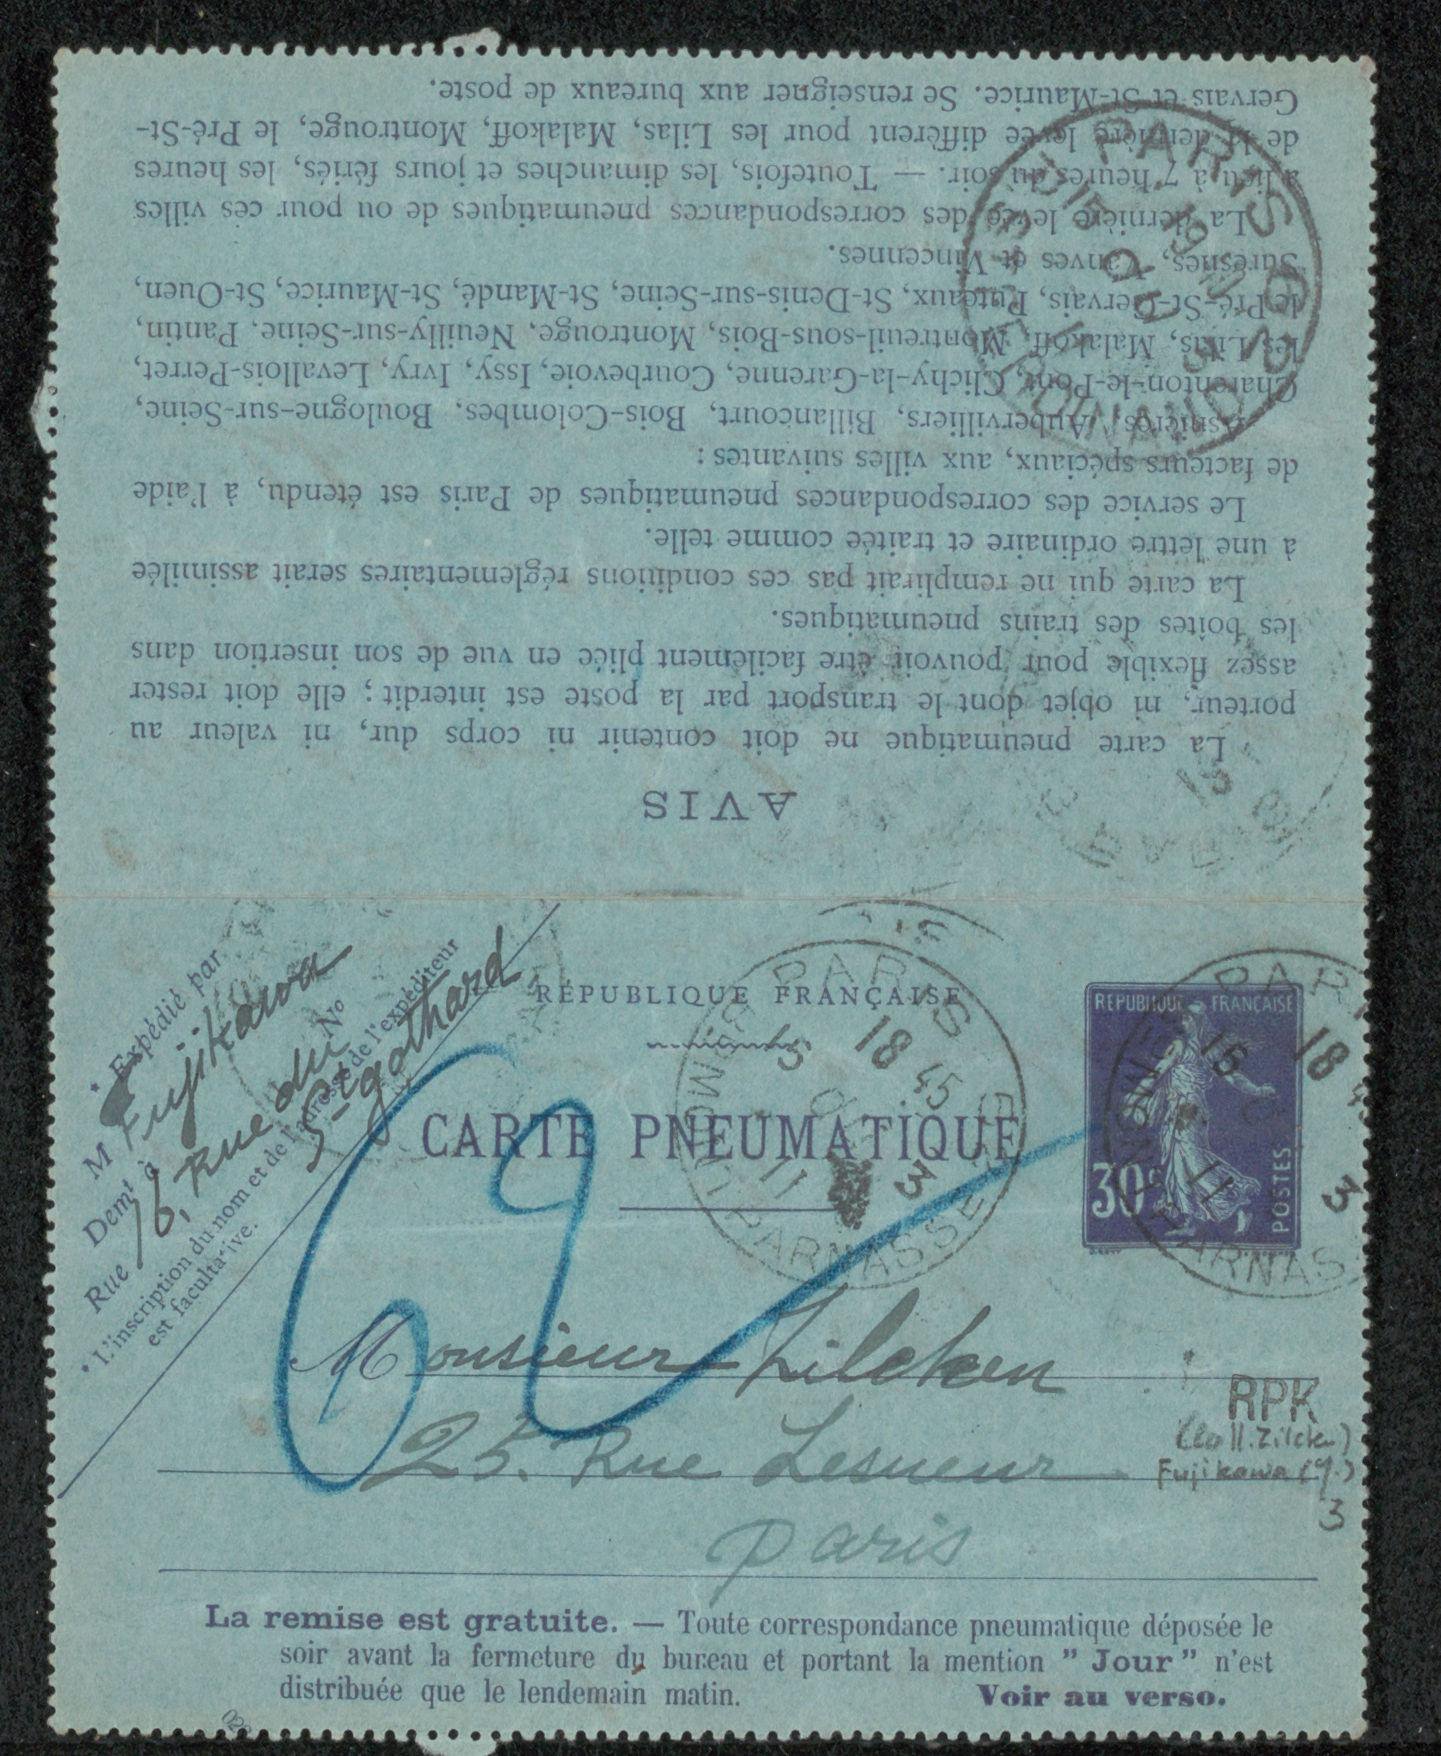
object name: postcard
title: Briefkaart aan Philip Zilcken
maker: j. fujikawa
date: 1911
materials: ink, paper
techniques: pen, writing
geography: paris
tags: the hague, painter, draughtsman, philip zilcken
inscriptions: collector's mark: ‘RPK’